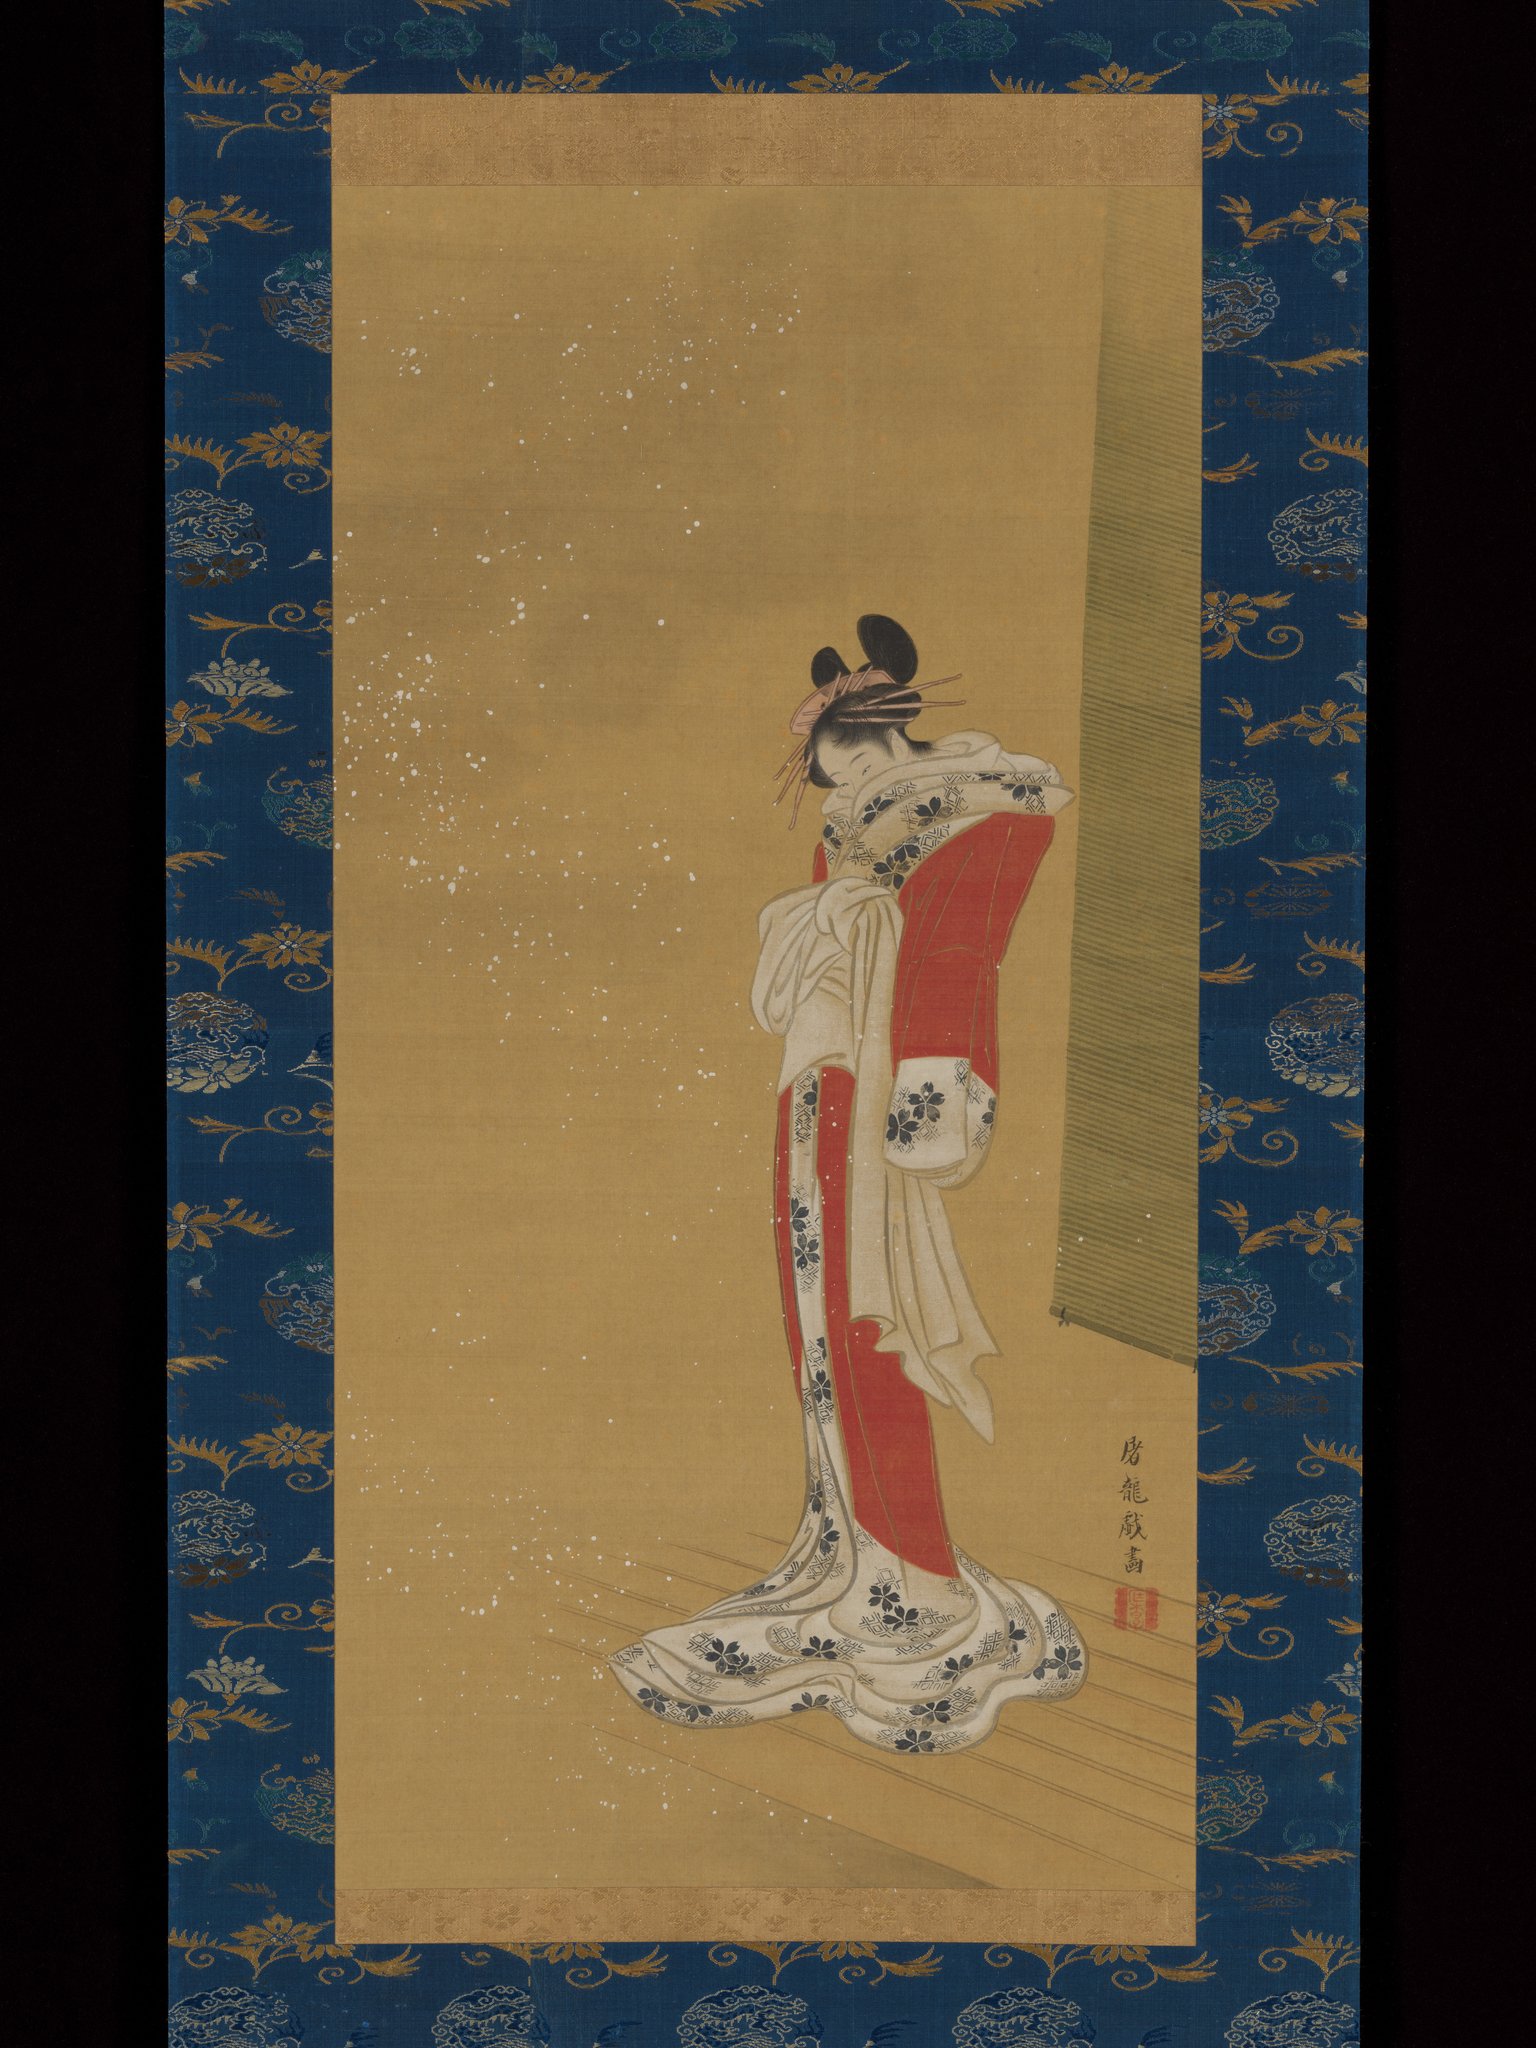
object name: hanging scroll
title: Beauty on a Veranda in Snow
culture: japanese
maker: sakai hōitsu 酒井抱一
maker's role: artist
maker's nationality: japanese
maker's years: 1761-1828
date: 1794-1795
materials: ink, silk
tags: women